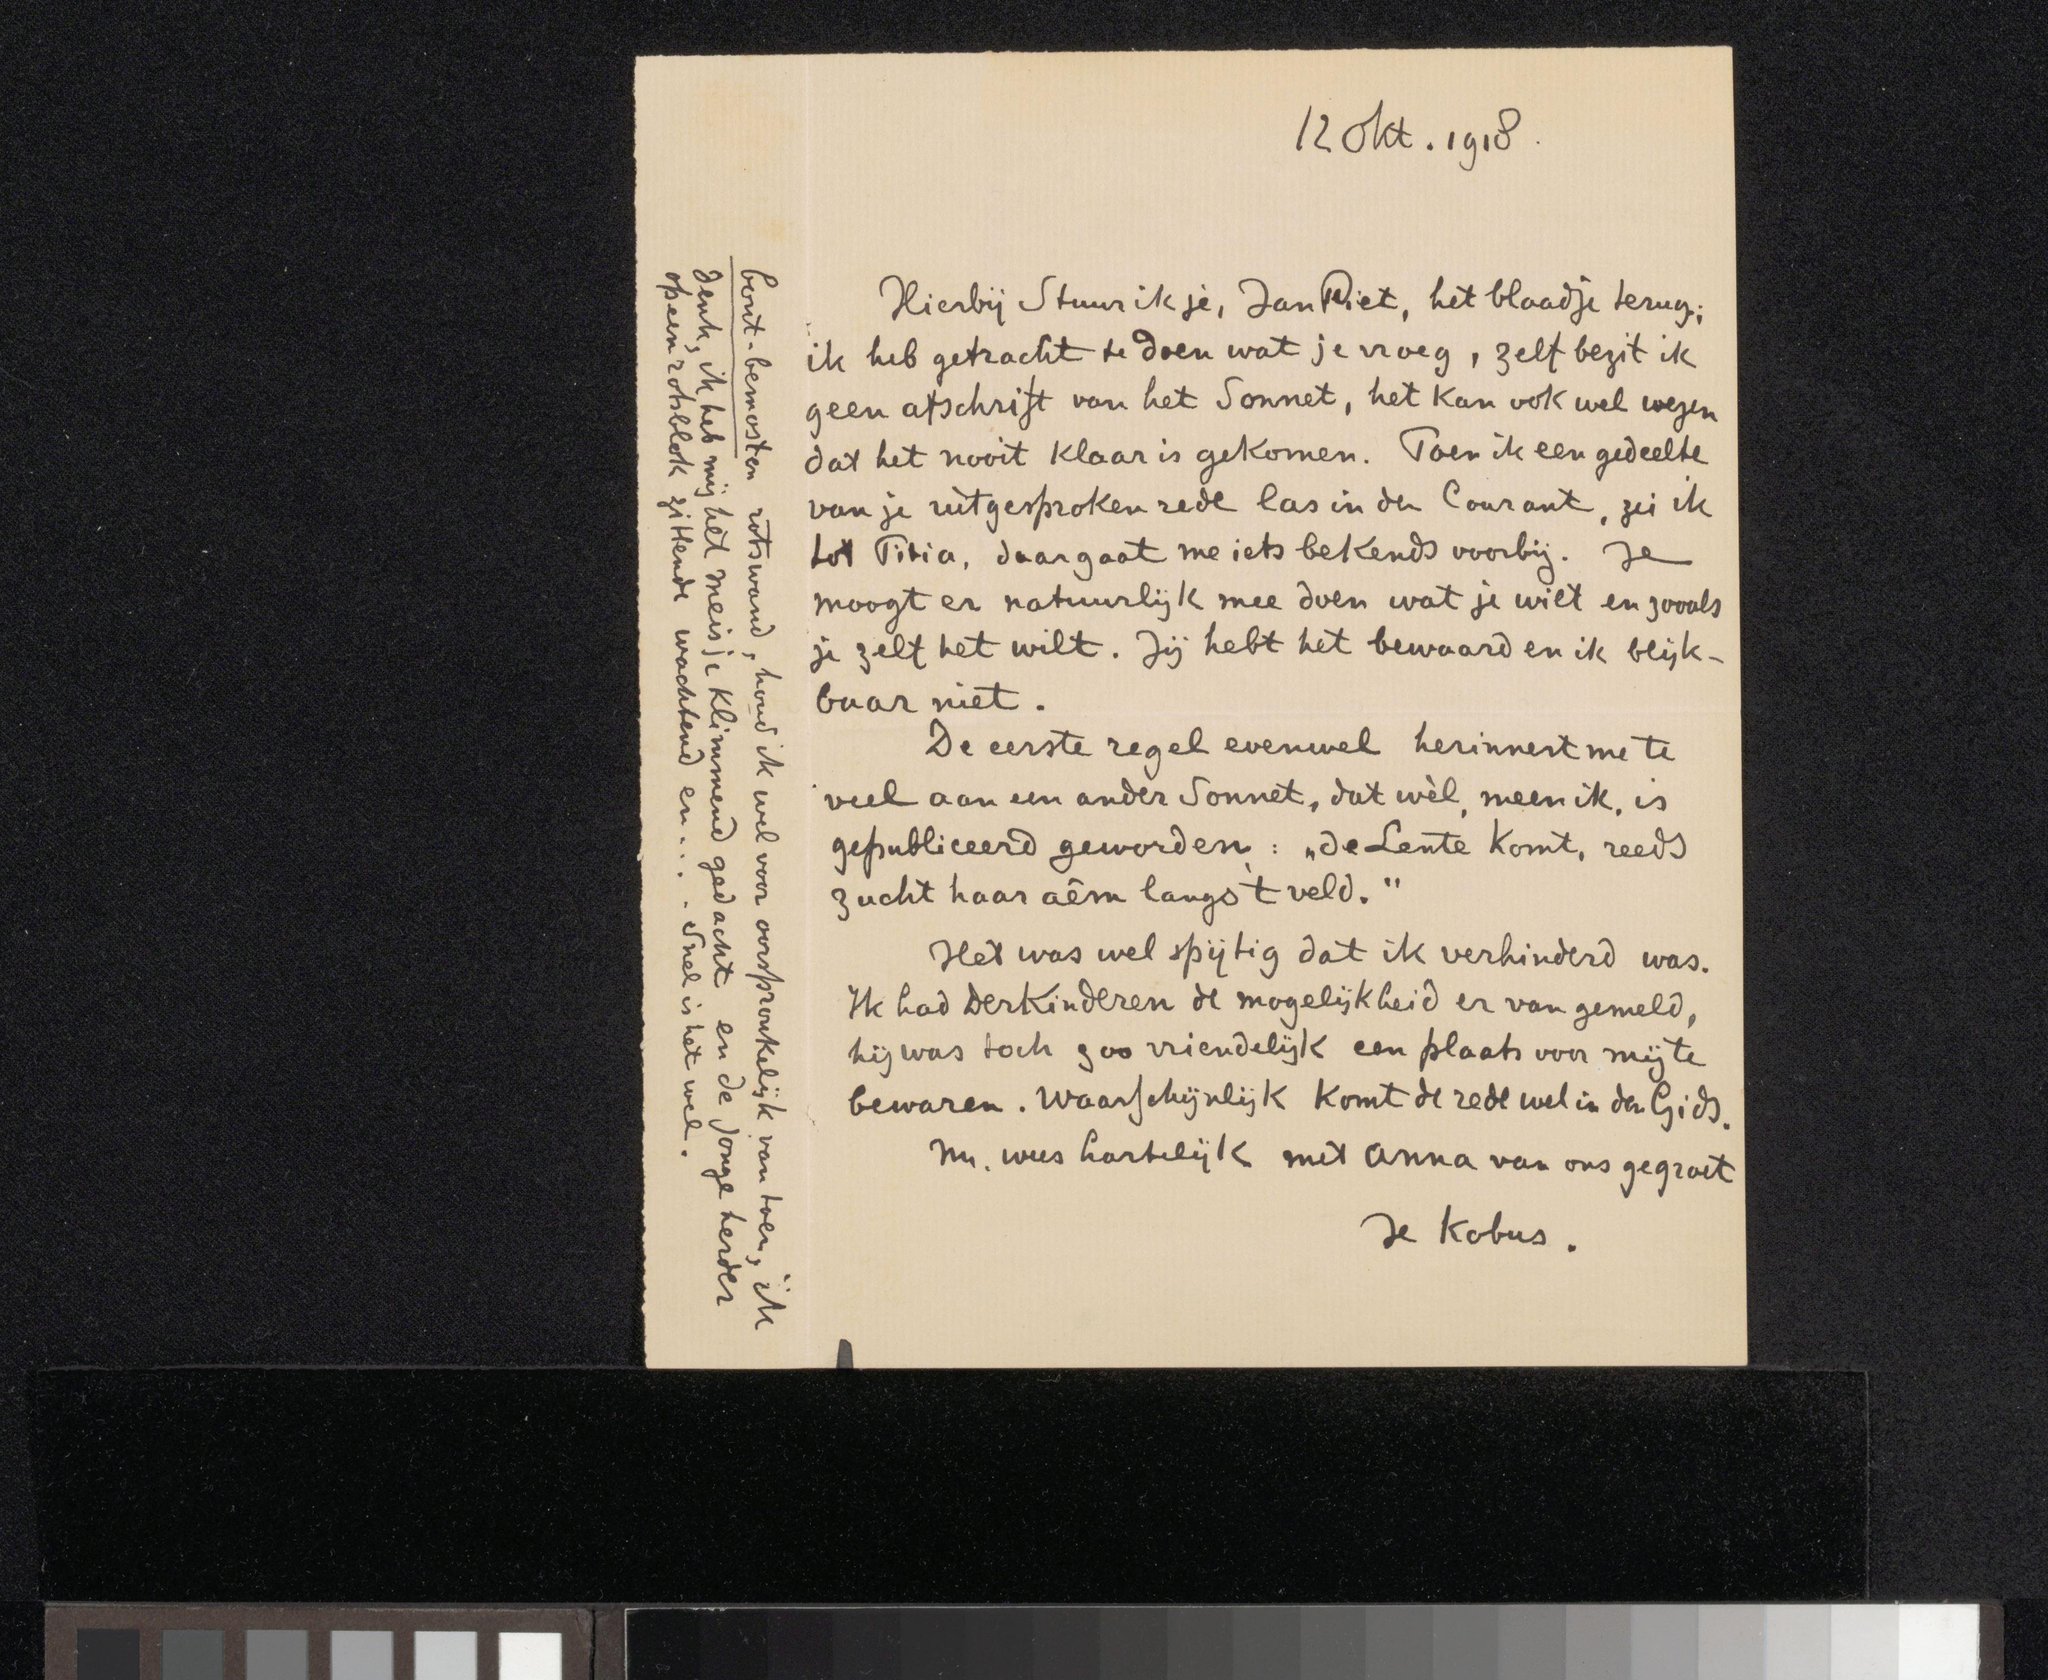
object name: letter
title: Brief aan Jan Veth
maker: jac van looij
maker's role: draughtsman, painter, print maker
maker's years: 1855-1930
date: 1918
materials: ink, paper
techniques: pen, writing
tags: dordrecht, amsterdam, painter, print maker, draughtsman, designer, jan veth, antoon derkinderen, literature ~ arts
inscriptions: watermark, collector's mark: ‘RPK’